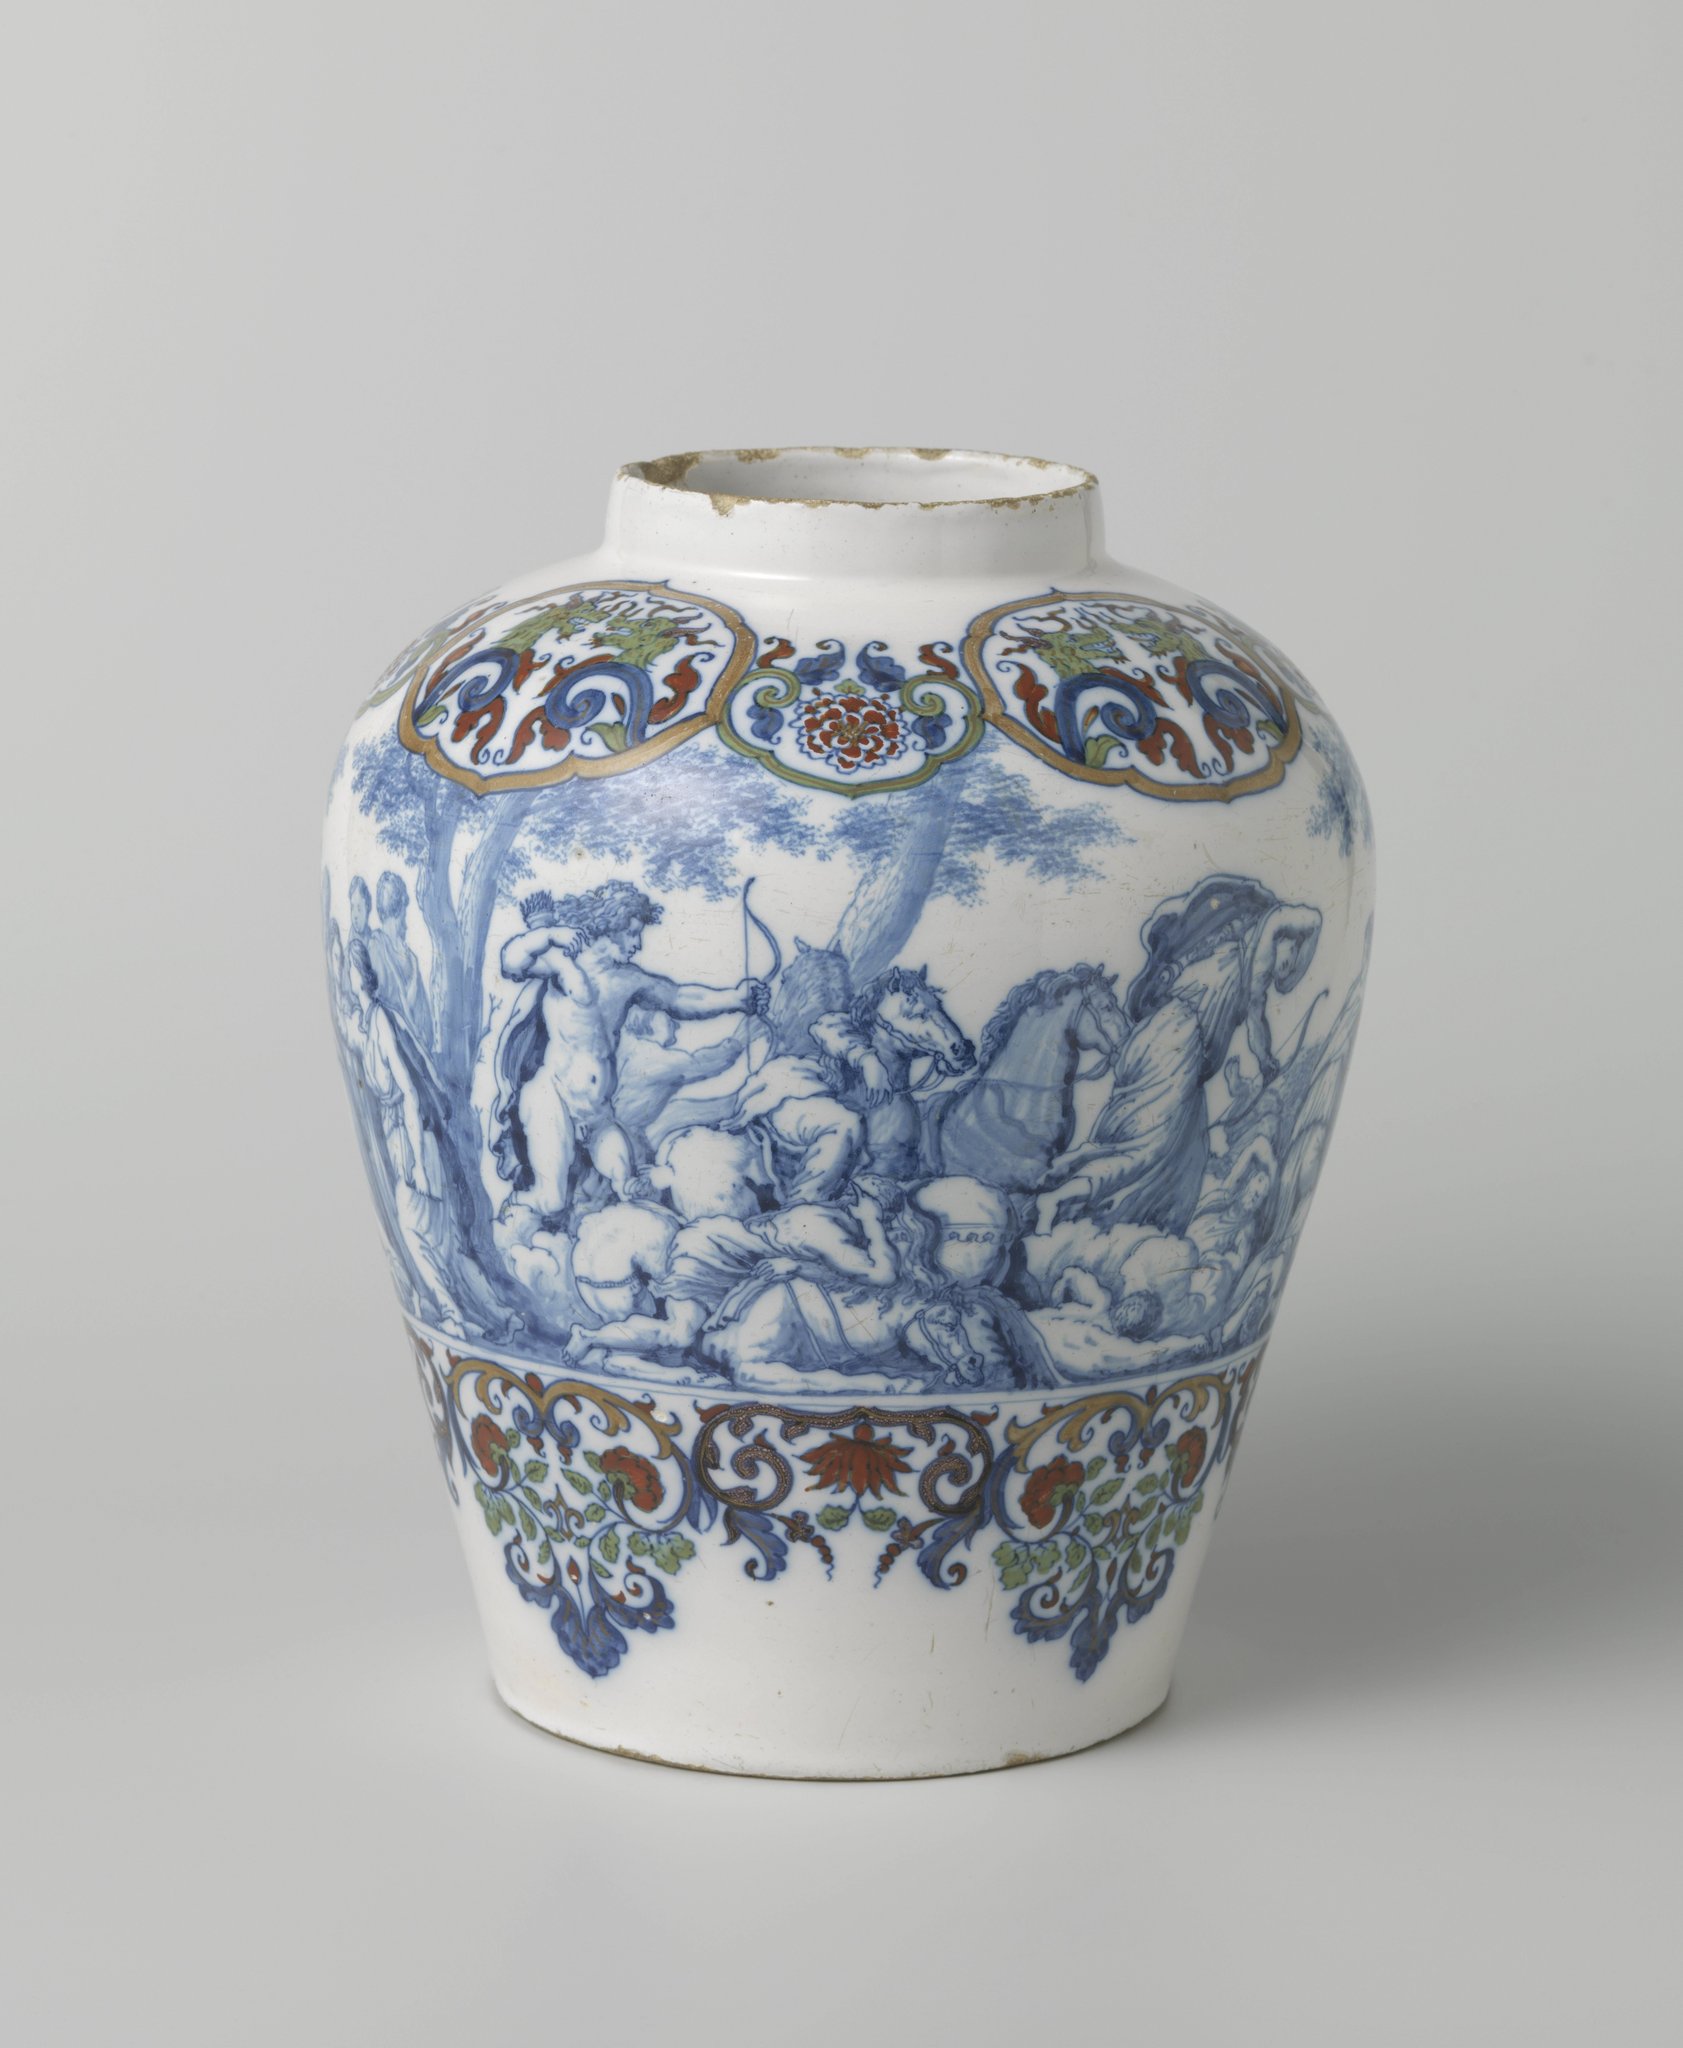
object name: pot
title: Jar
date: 1680-1685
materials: earthenware, glaze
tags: riding a horse, ass, or mule; rider, horseman, archer's weapons: bow and arrow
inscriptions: mark: ‘IW(ineen)’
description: Pot van faïence, veelkleurig beschilderd.